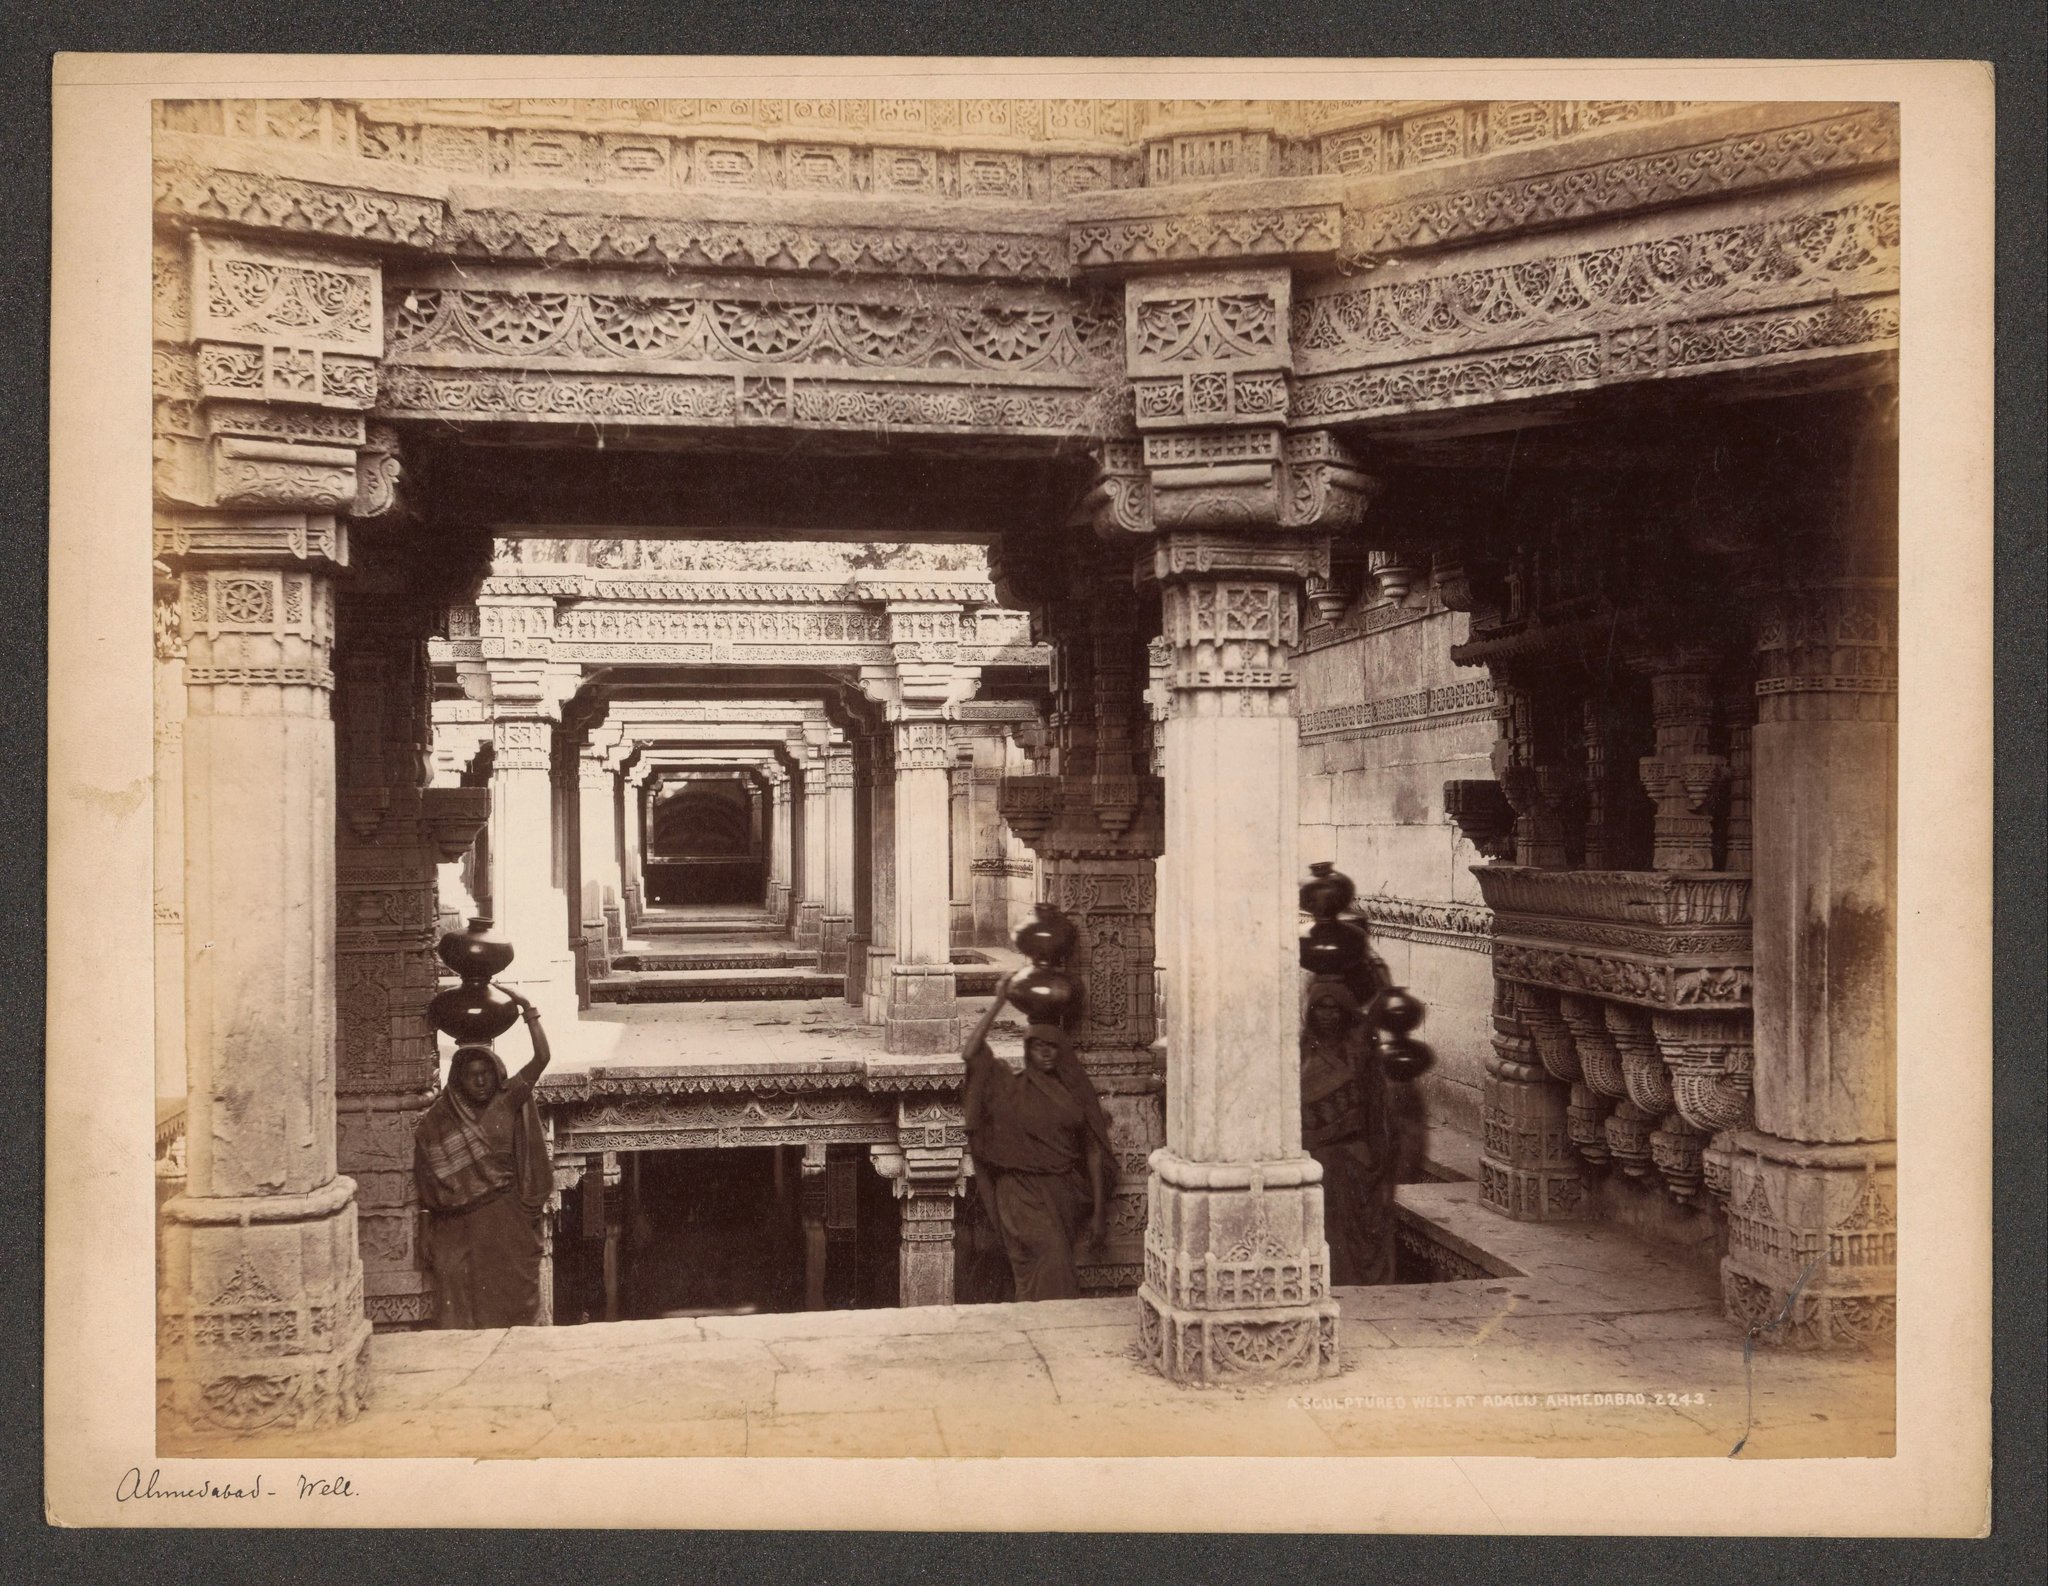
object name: photograph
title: Women with water jugs on the steps of the water well of Adalaj near Ahmedabad, Gujarat, India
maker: colin murray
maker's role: fotograaf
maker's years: 1840-1884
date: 1870-1873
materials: cardboard, paper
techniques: albumen print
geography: adalaj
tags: well, column, pillar ~ architecture, carrying something on the head or on the shoulders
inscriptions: number: ‘14’, inscription: ‘Ahmedabad-Well.’, inscription: ‘B&S of Bourne (t)’, number: ‘2243’, title: ‘A sculptured well at Adalij, Ahmebadad.’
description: After Samuel Bourne returned to England in 1870, Colin Murray took over his role as chief photographer at Bourne & Shepherd. Murray here photographed a famous architectural tradition in India: wells with steps, which were built by rulers in the arid regions of western India. The well of Adalaj was built in 1498 by Queen Rudadevi, in memory of her late husband Rana Veer Singh.